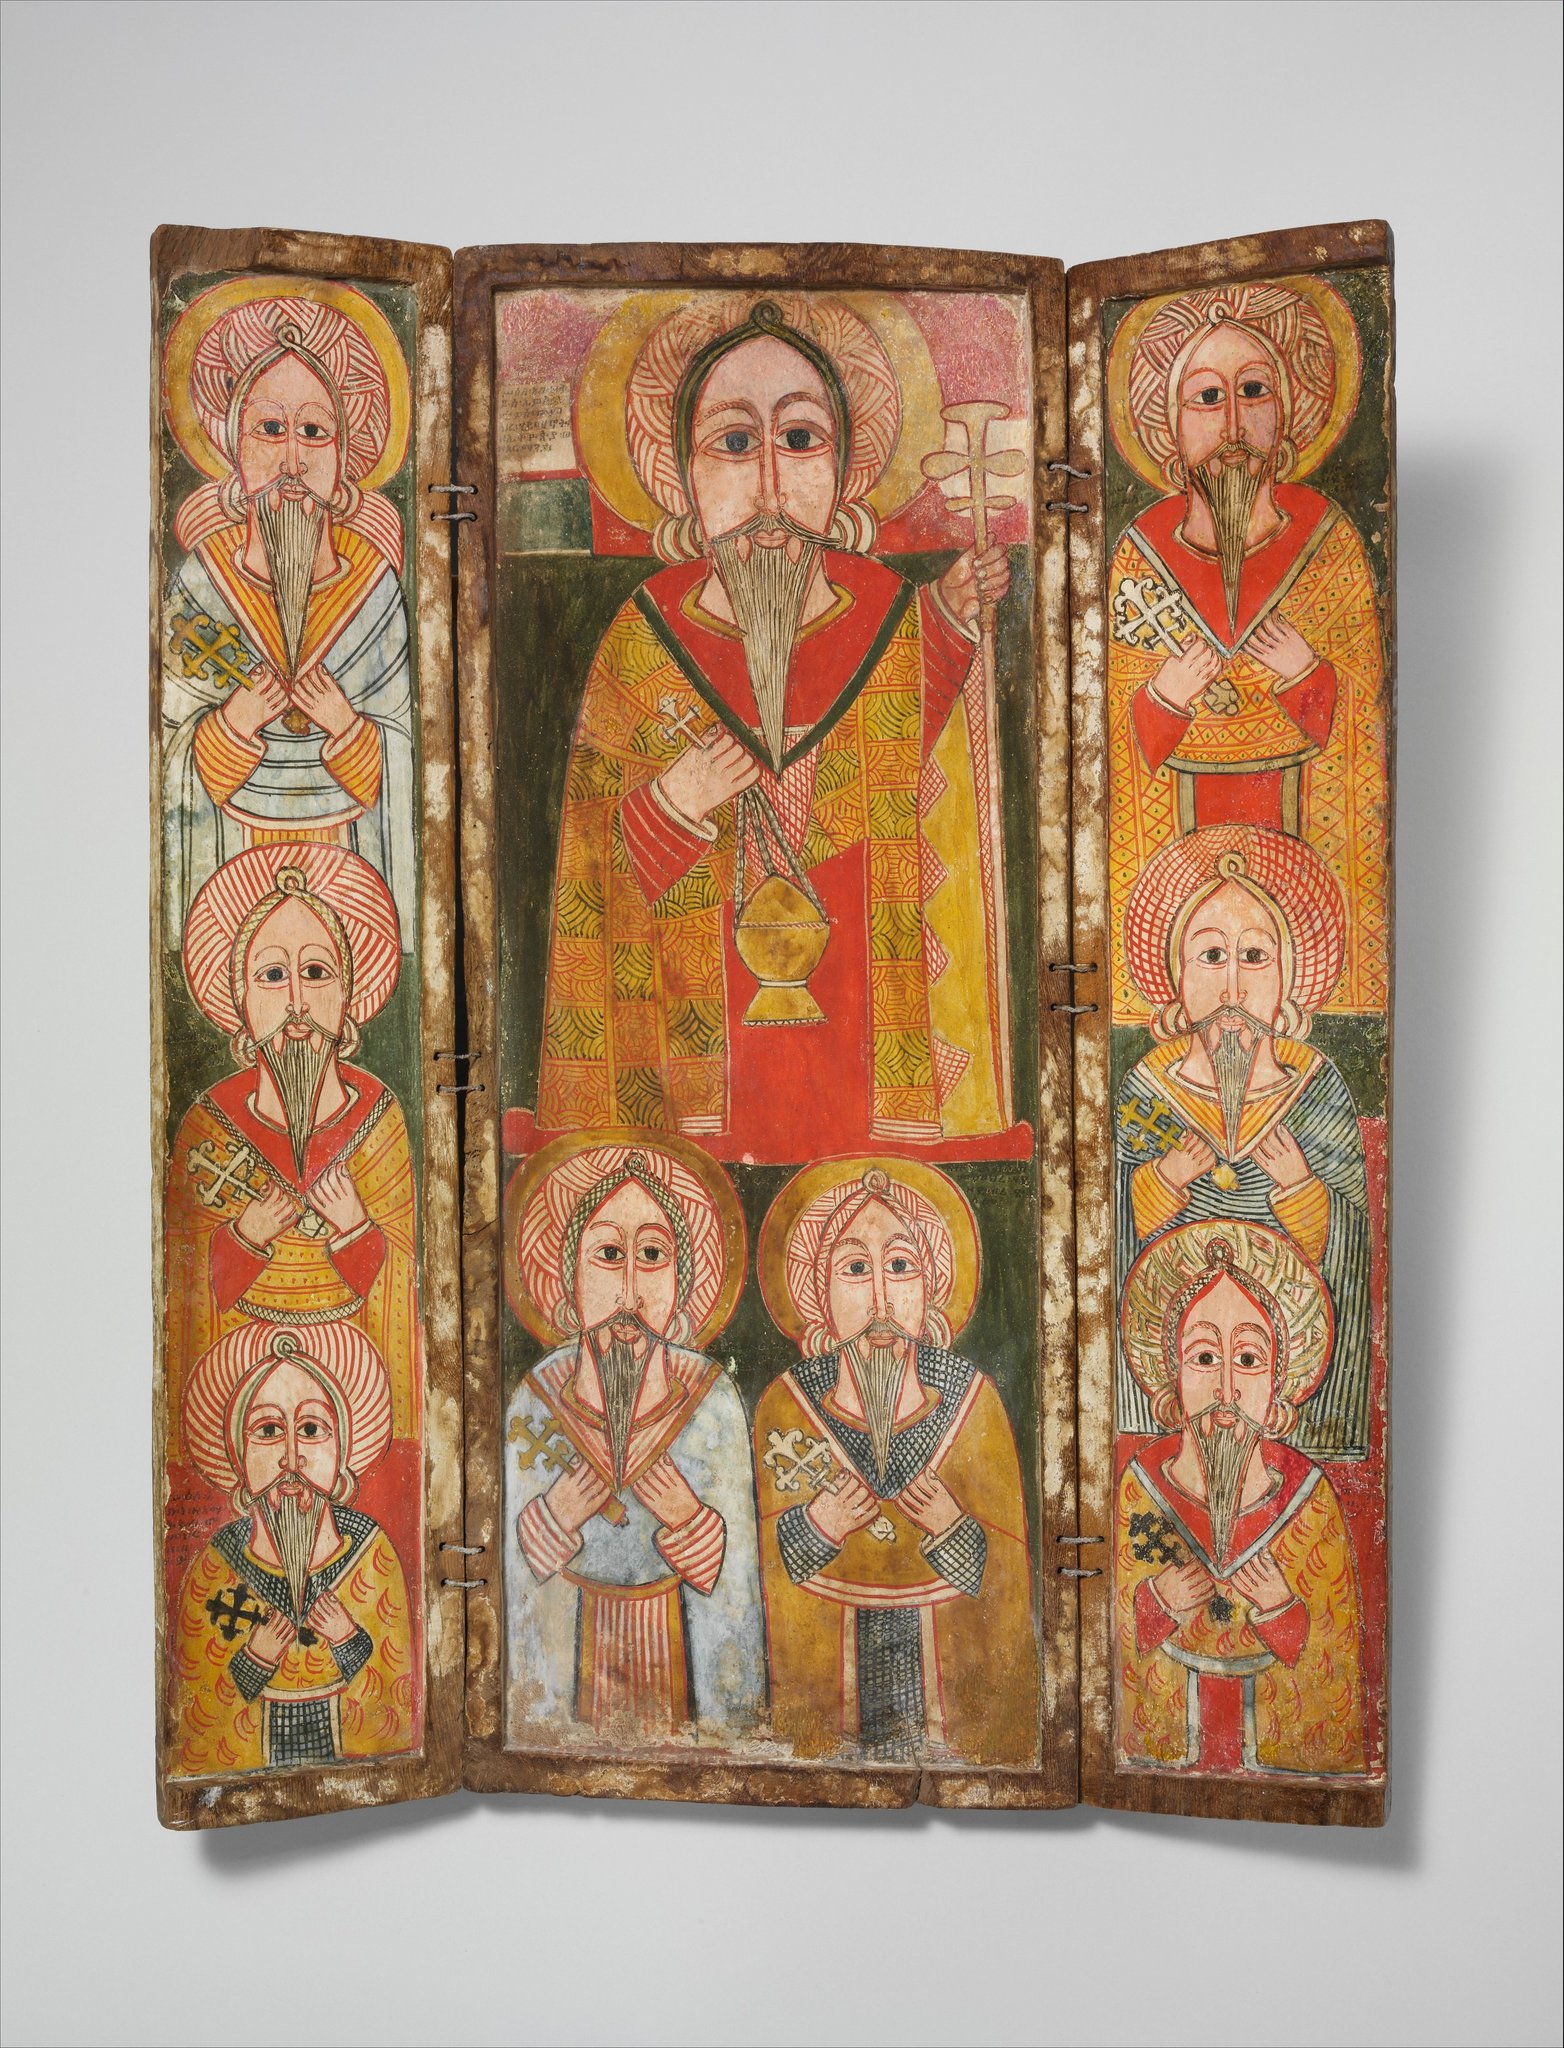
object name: icon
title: Icon triptych of Ewosṭatewos and eight of his disciples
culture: amhara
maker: northern highlands artist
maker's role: artist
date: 1667-1700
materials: cord, paint, wood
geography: ethiopia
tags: men,saints